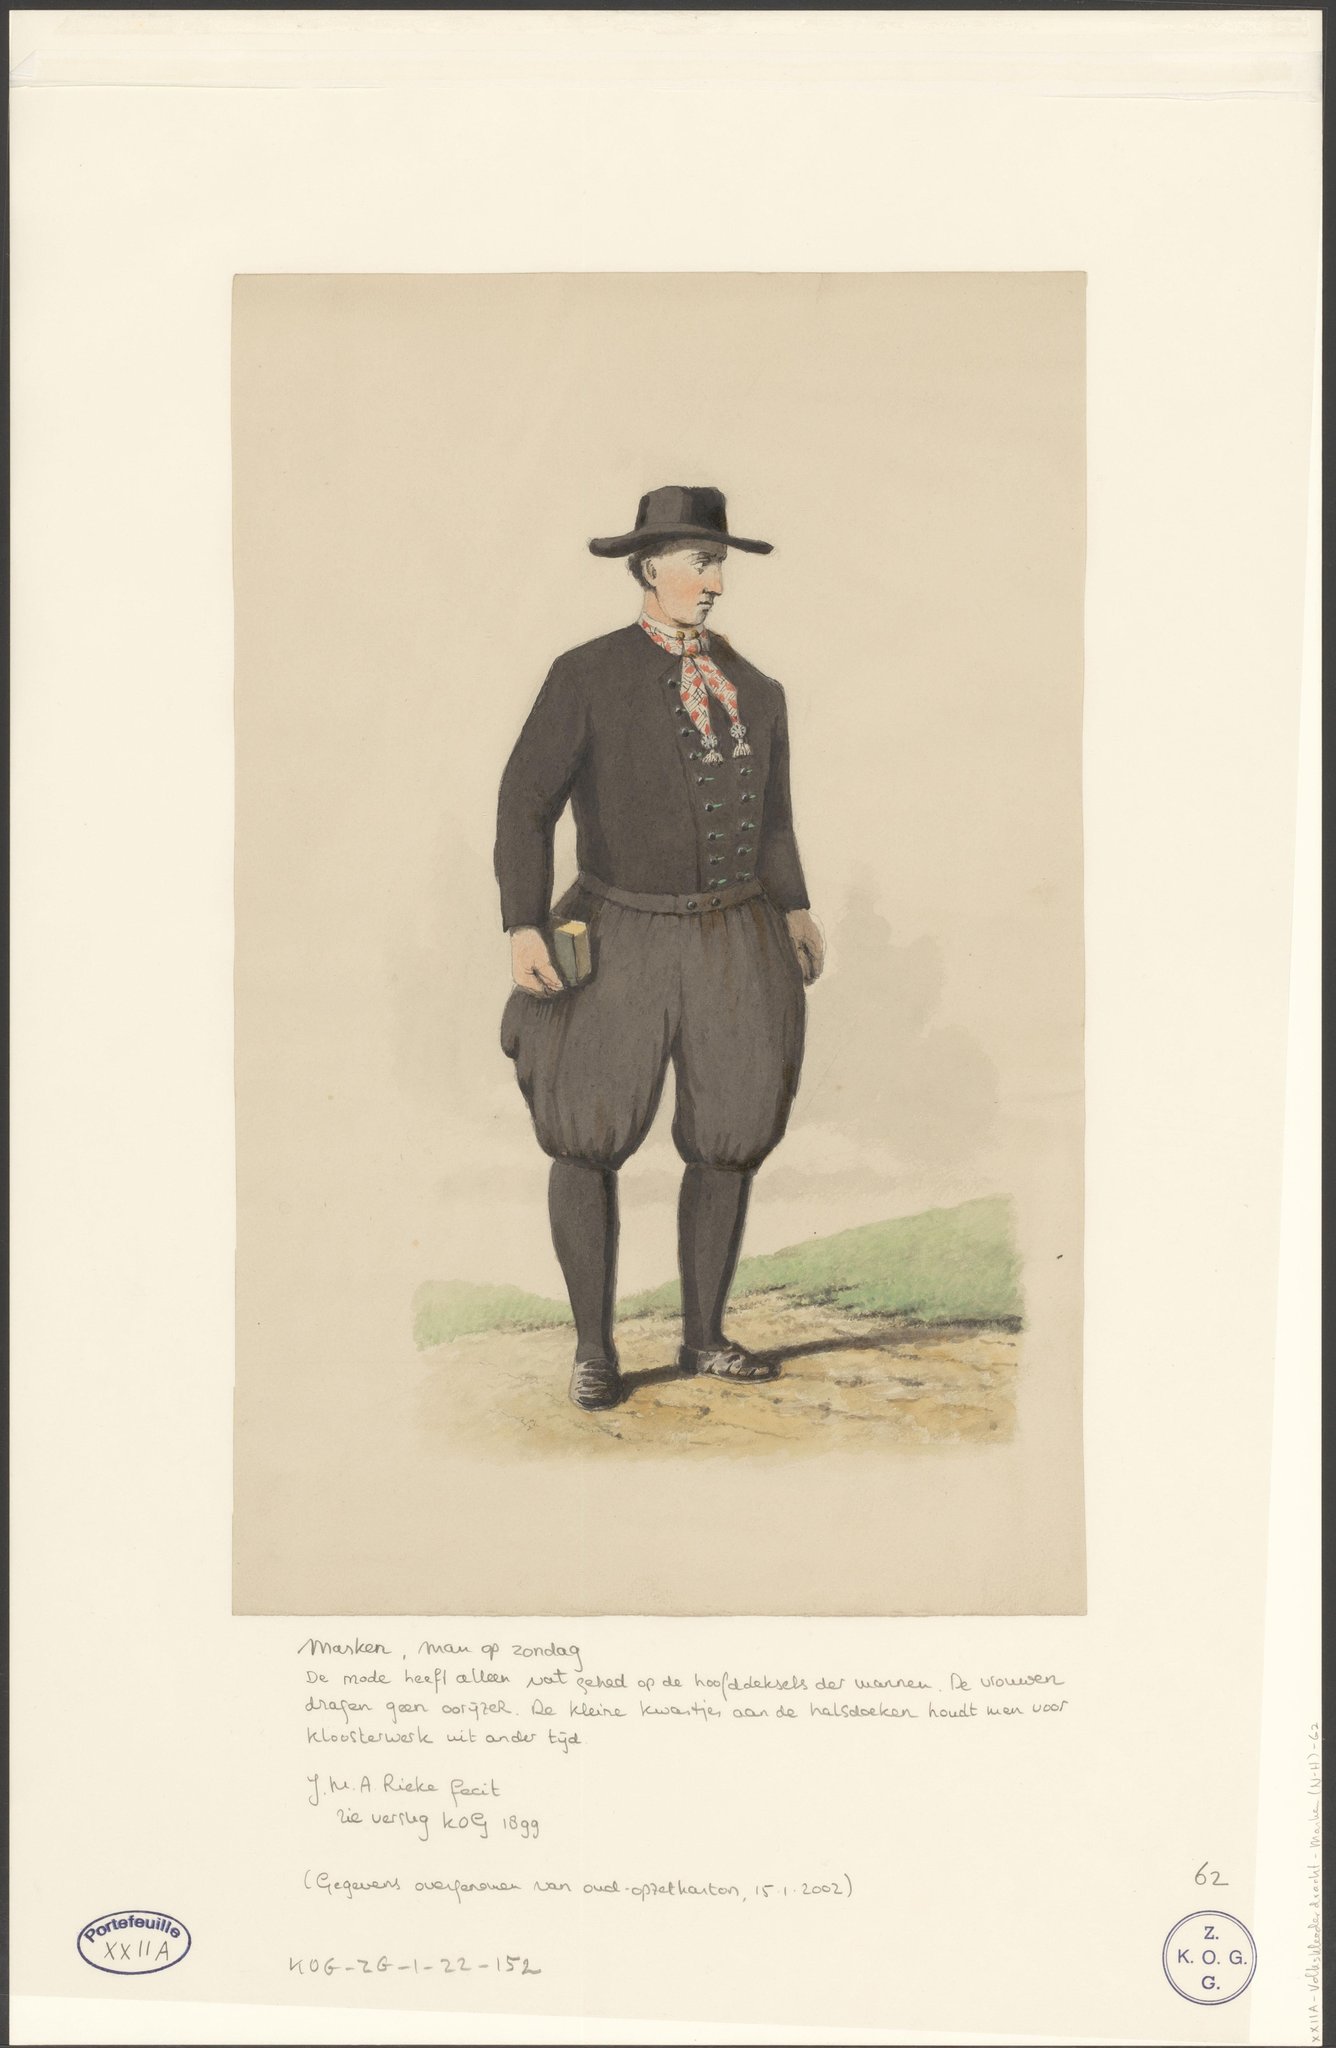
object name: drawing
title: Marken, man op zondag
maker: johan martinus anthon rieke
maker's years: 1851-1899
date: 1896-1898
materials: paper, watercolor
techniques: brush, hand coloring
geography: netherlands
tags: going to church, clothes, costume (+ men's clothes), folk costume, regional costume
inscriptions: collector's mark, collector's mark: Lugt 1641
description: Man van Marken, in zondagse dracht in het zwart op weg naar de kerk. Tekening vervaardigd voor de tentoonstelling over Nederlandse klederdrachten gehouden in het Stedelijk Museum te Amsterdam in september 1898. Onderwerpsrubrieken binnen de Atlas Zeden en Gewoonten: De Kleeding, Volkskleederdracht, Noord-Holland.